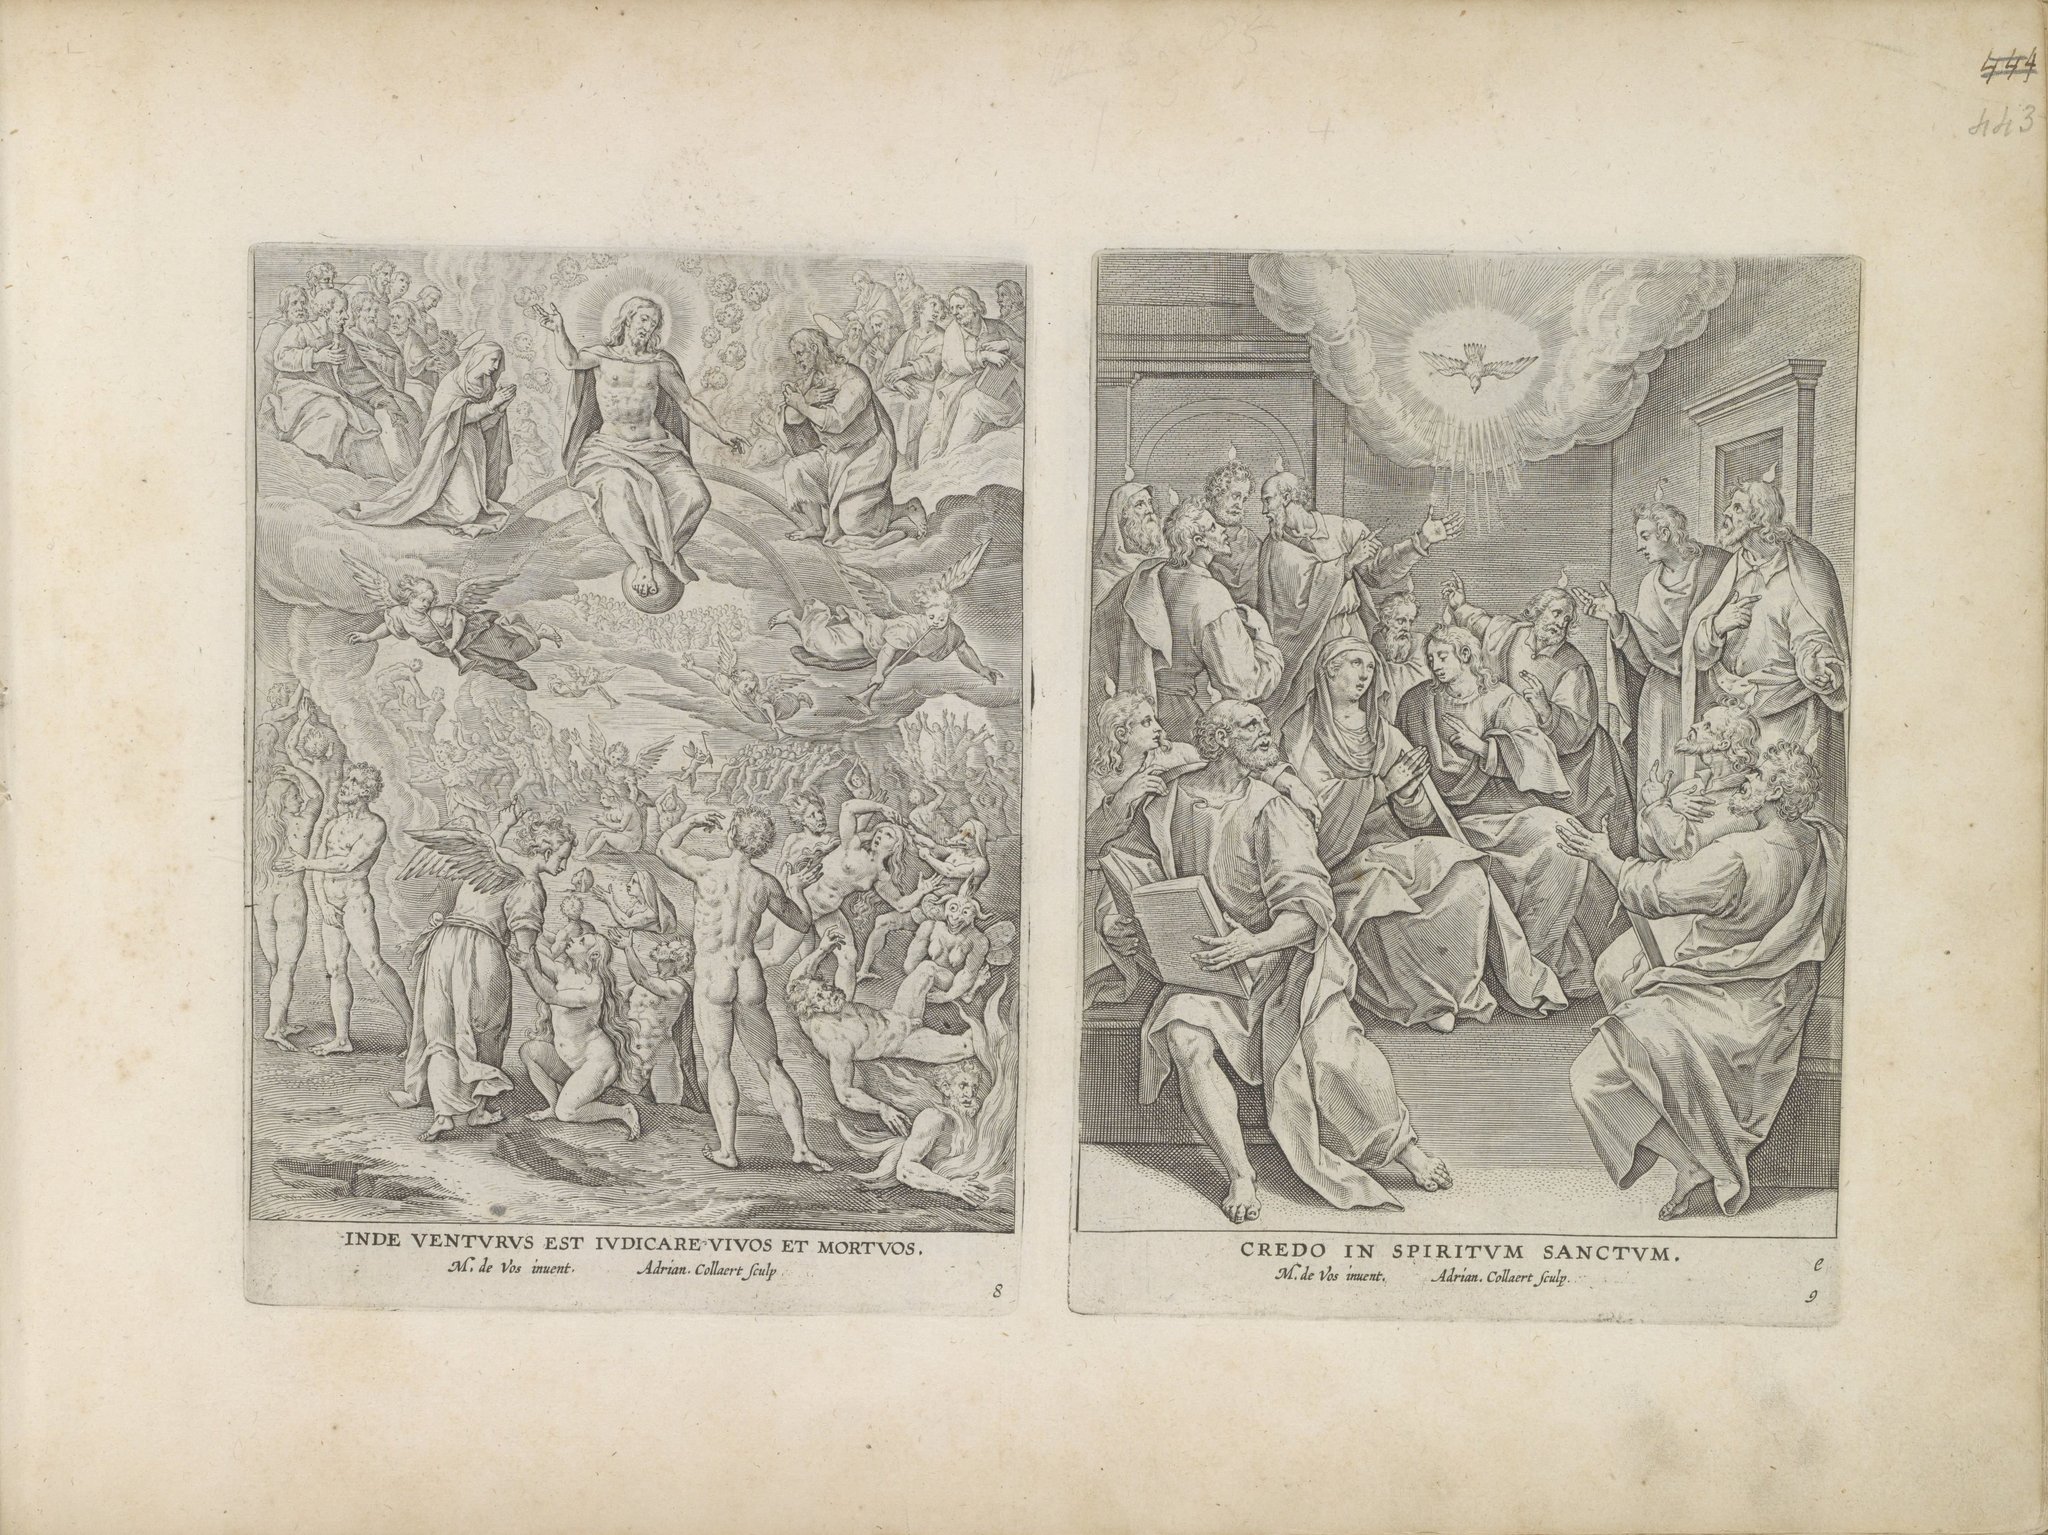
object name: album leaf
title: Apostolische geloofsbelijdenis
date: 1570-1618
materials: paper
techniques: engraving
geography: amsterdam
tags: comprehensive representation of last judgement: christ (with sword and lily), often surrounded by elders and sometimes accompanied by mary and john the baptist, appears in the sky with trumpeting angels (and sometimes angels holding the instruments of the passion); after the resurrection of the dead the blessed are led to heaven by angels, and the damned are dragged into hell by devils, 'inde venturus est iudicare vivos et mortuos' ~ articles of faith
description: Illustratie van het zevende geloofsartikel (vandaar zal Hij komen oordelen de levenden en de doden) van de apostolische geloofsbelijdenis. Christus zit op een regenboog in de wolken met de maagd Maria en Johannes geknield naast hem. Hij oordeelt over de wereld tijdens het Laatste Oordeel. Rondom hen de apostelen. Op de aarde herrijzen alle doden uit hun graven. Zij worden door engelen naar de hemel geleid (links) of door duivels naar de hel gevoerd (rechts). Deze prent maakt deel uit van een album.